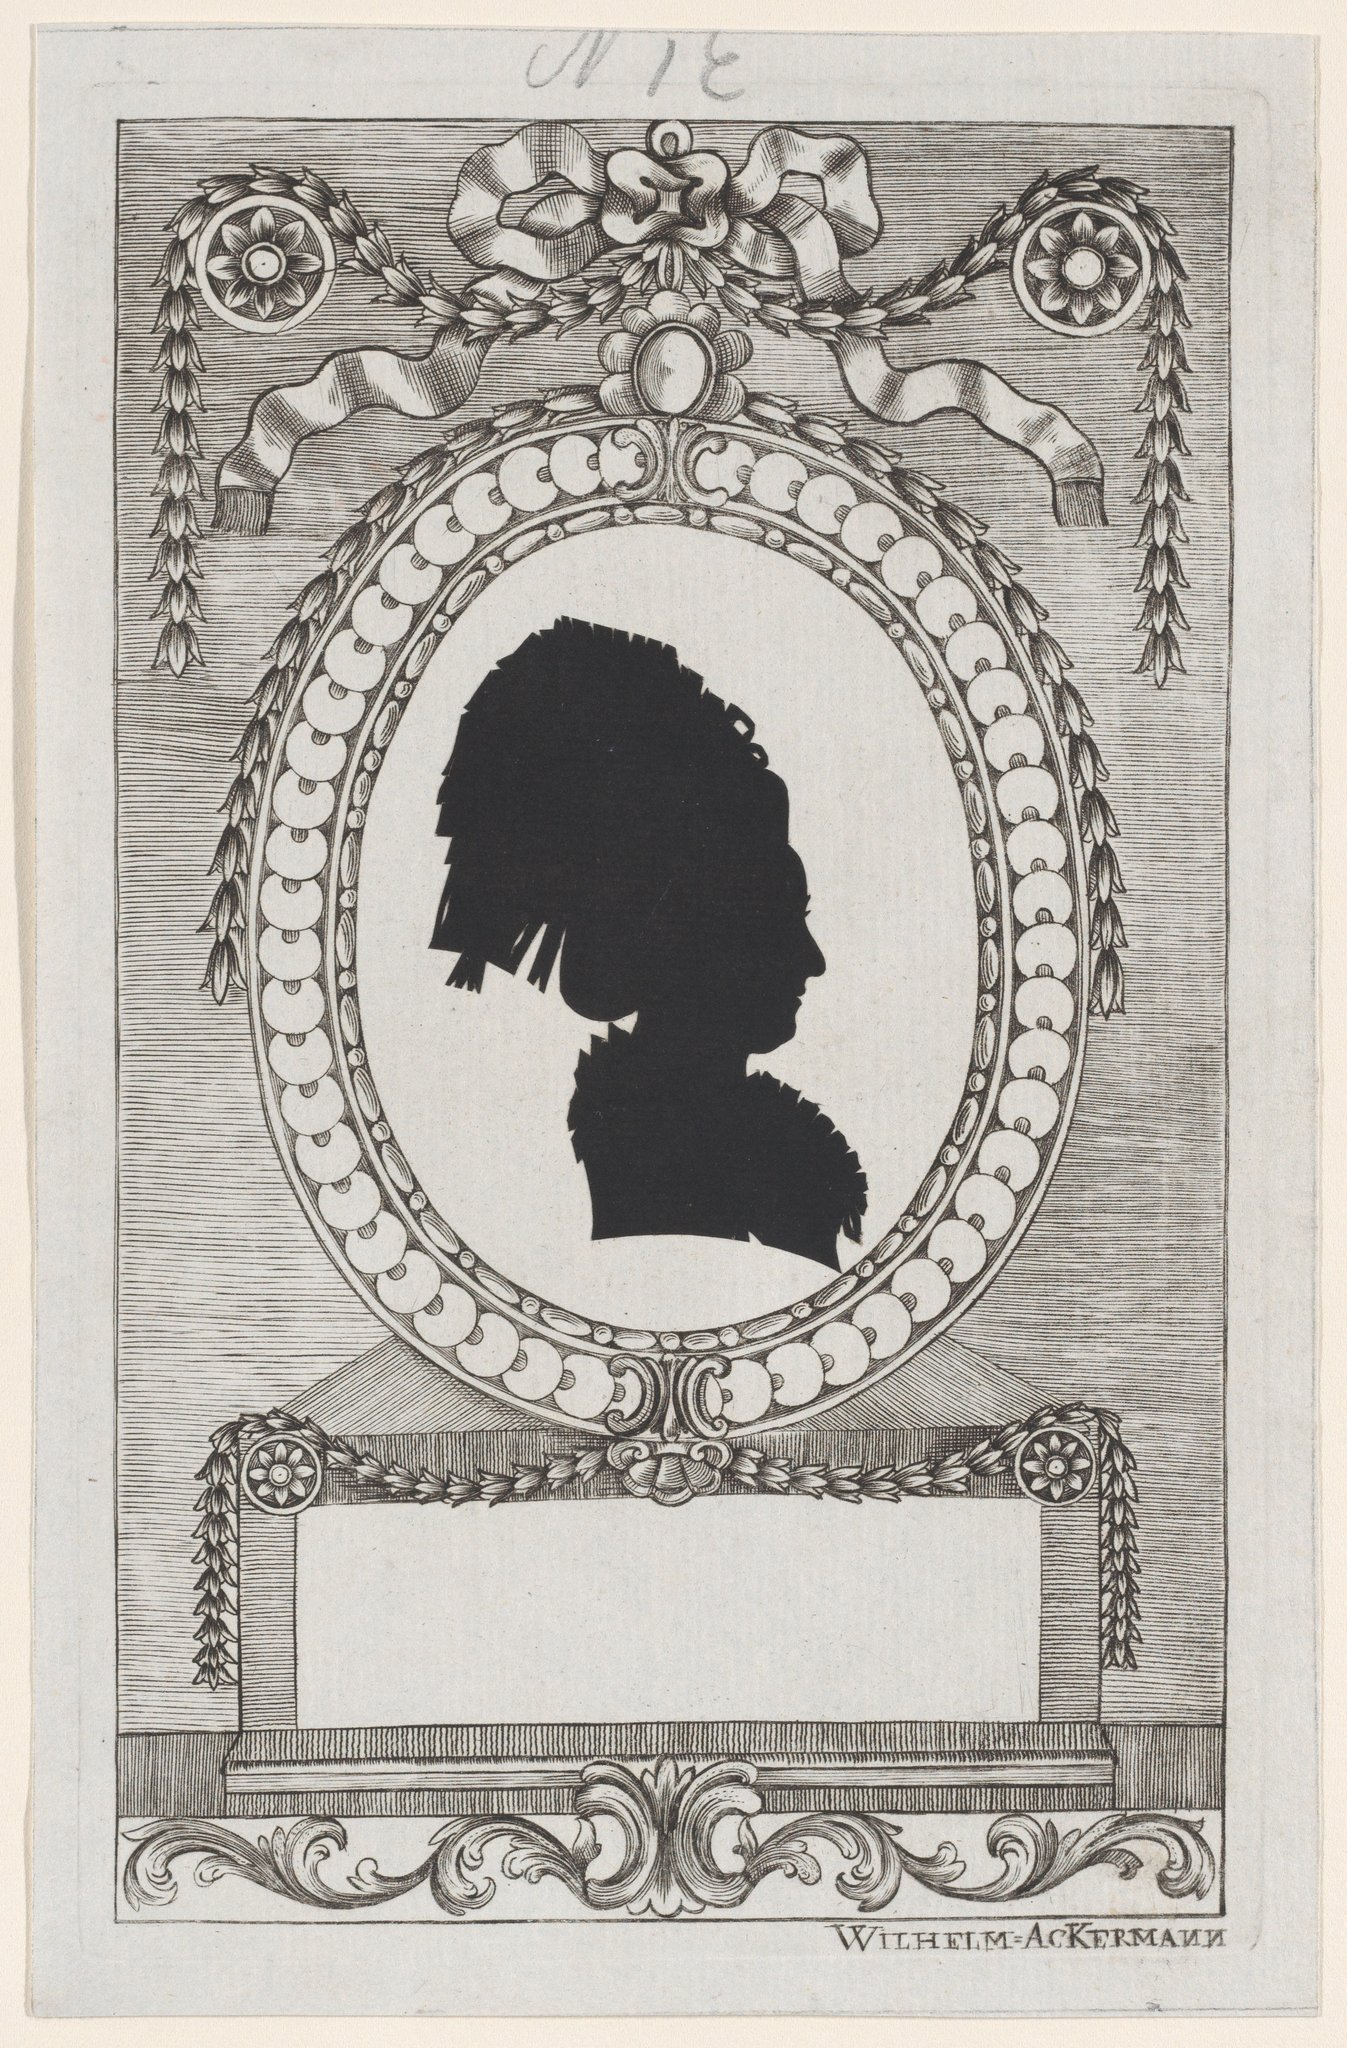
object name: print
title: Silhouette of Gräfin Enzenberg, Stiftsfräulein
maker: wilhelm ackermann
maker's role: artist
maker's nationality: german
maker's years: 1764-1834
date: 1784-1834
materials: paper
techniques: cutting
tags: women